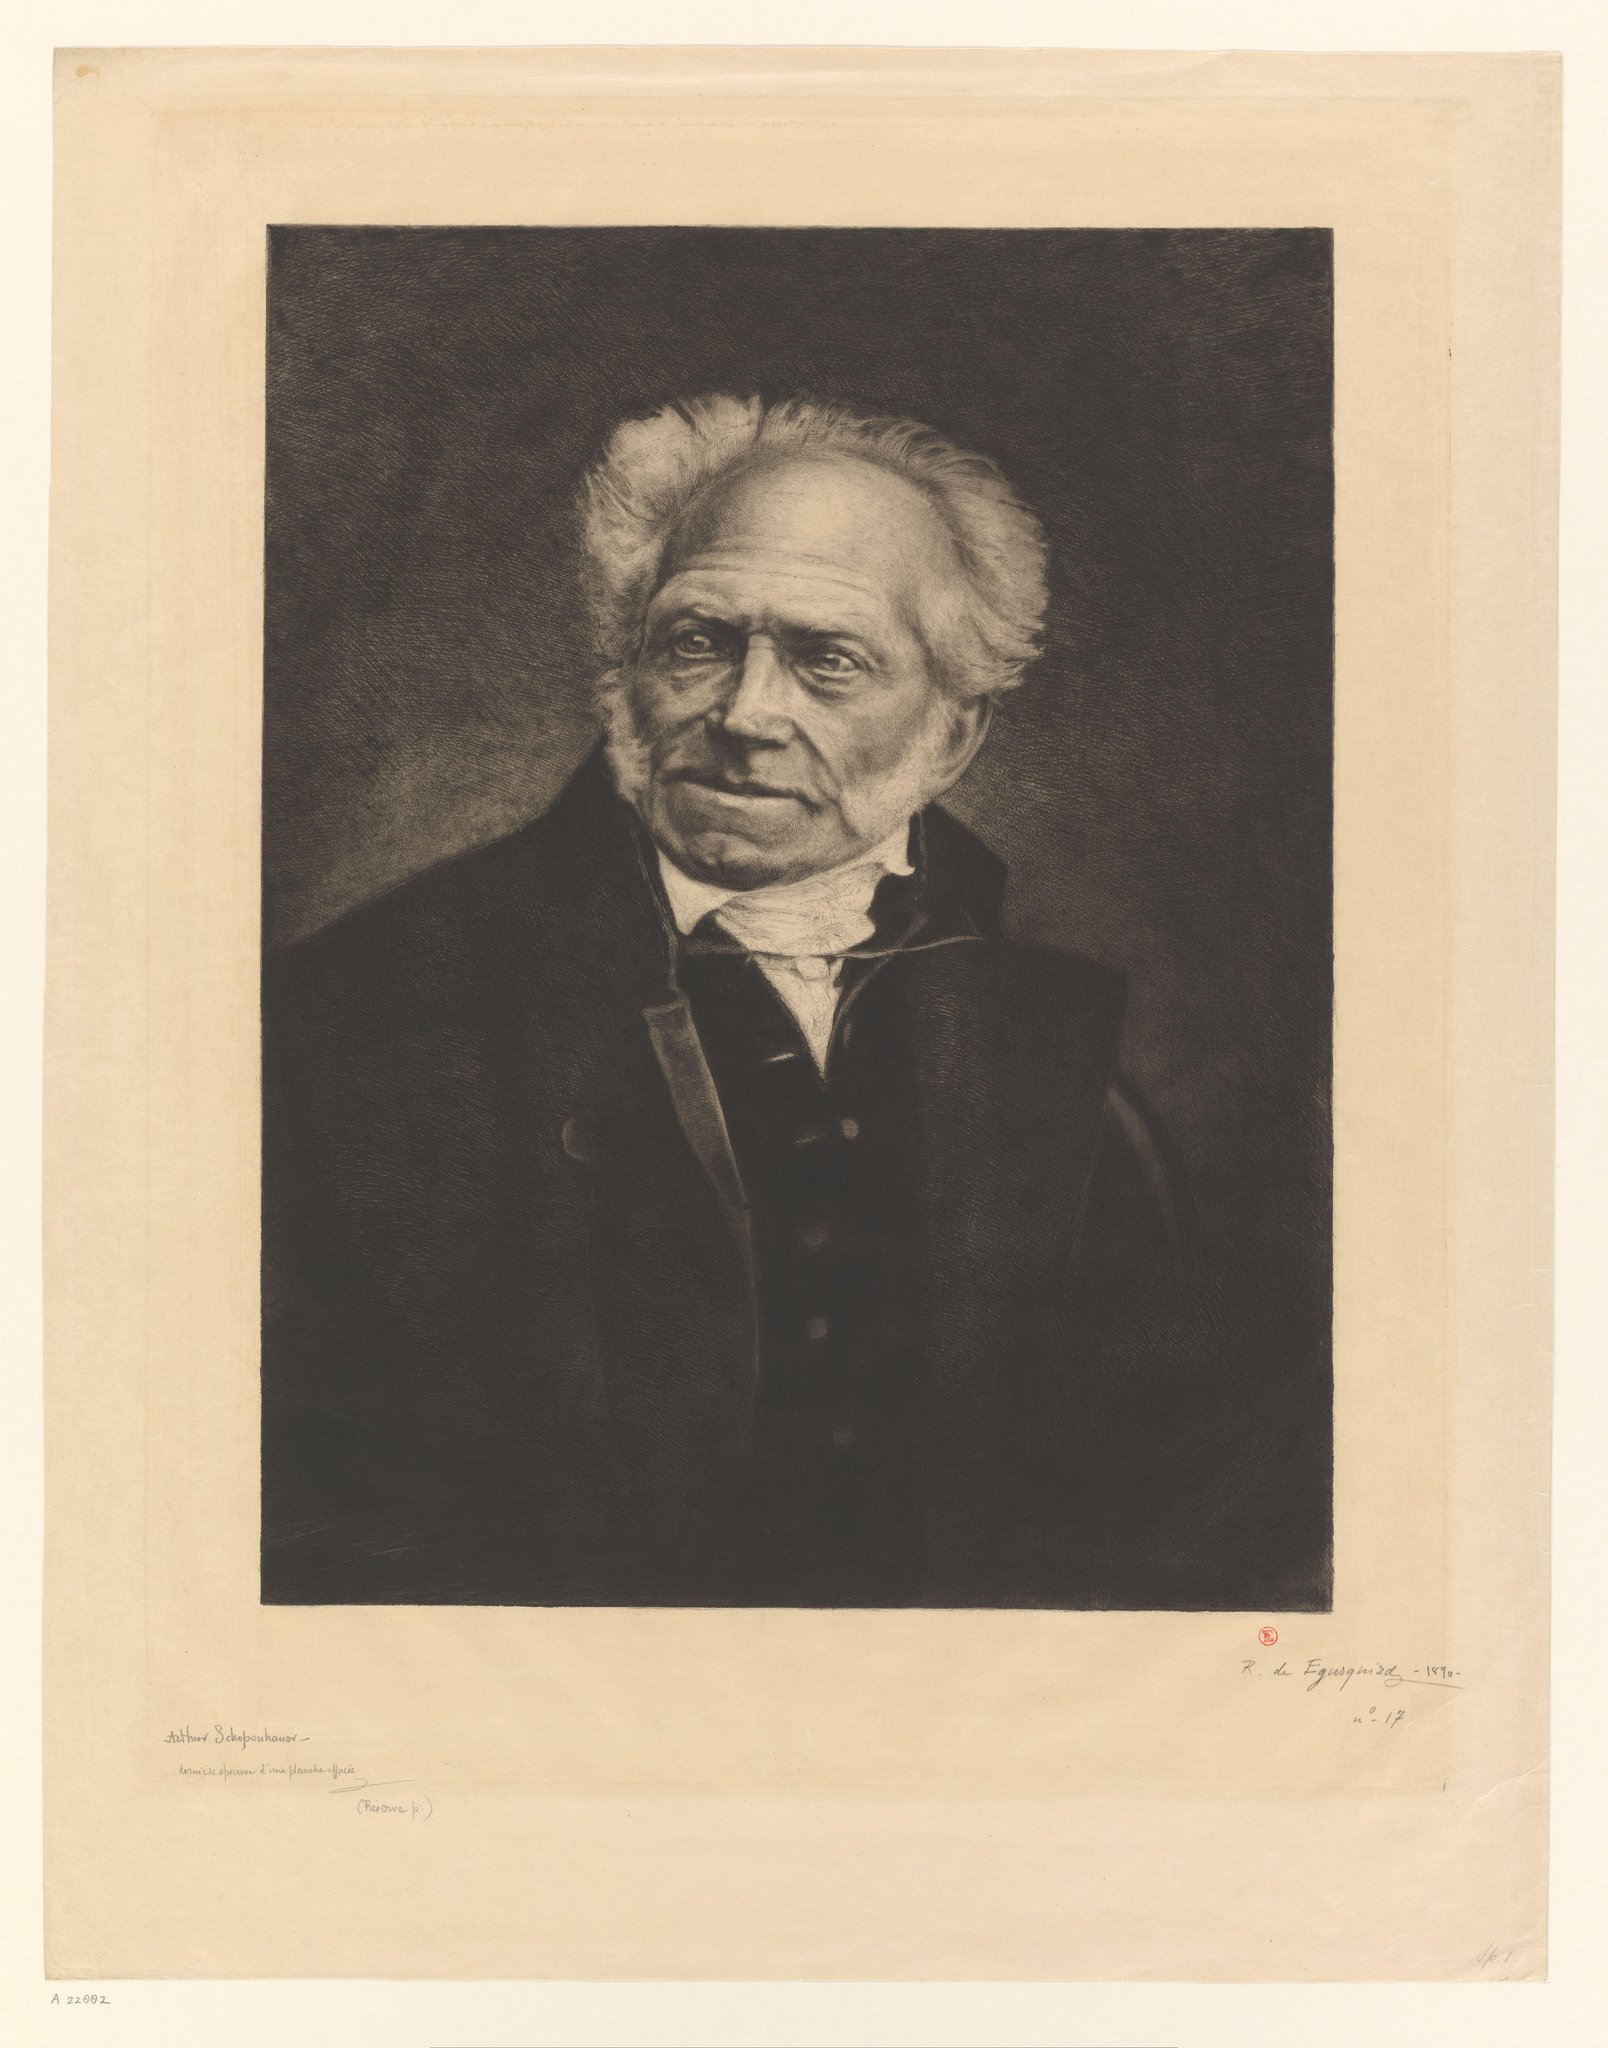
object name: print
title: Portret van Arthur Schopenhauer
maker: rogelio de egusquiza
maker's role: painter, print maker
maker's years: 1845-1915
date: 1890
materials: paper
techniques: aquatint, etching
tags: scholar, philosopher, historical persons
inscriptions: annotation: ‘Arthur Schopenhauer/ derniere epreuve d'une planche effacée/ (Reserve p.)’, collector's mark: Lugt 2228, workshop stamp: ‘monogram ER’, annotation: ‘no. 17’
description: Laatste afdruk van een daarna vernietigde plaat, volgens annotatie op recto linksonder.